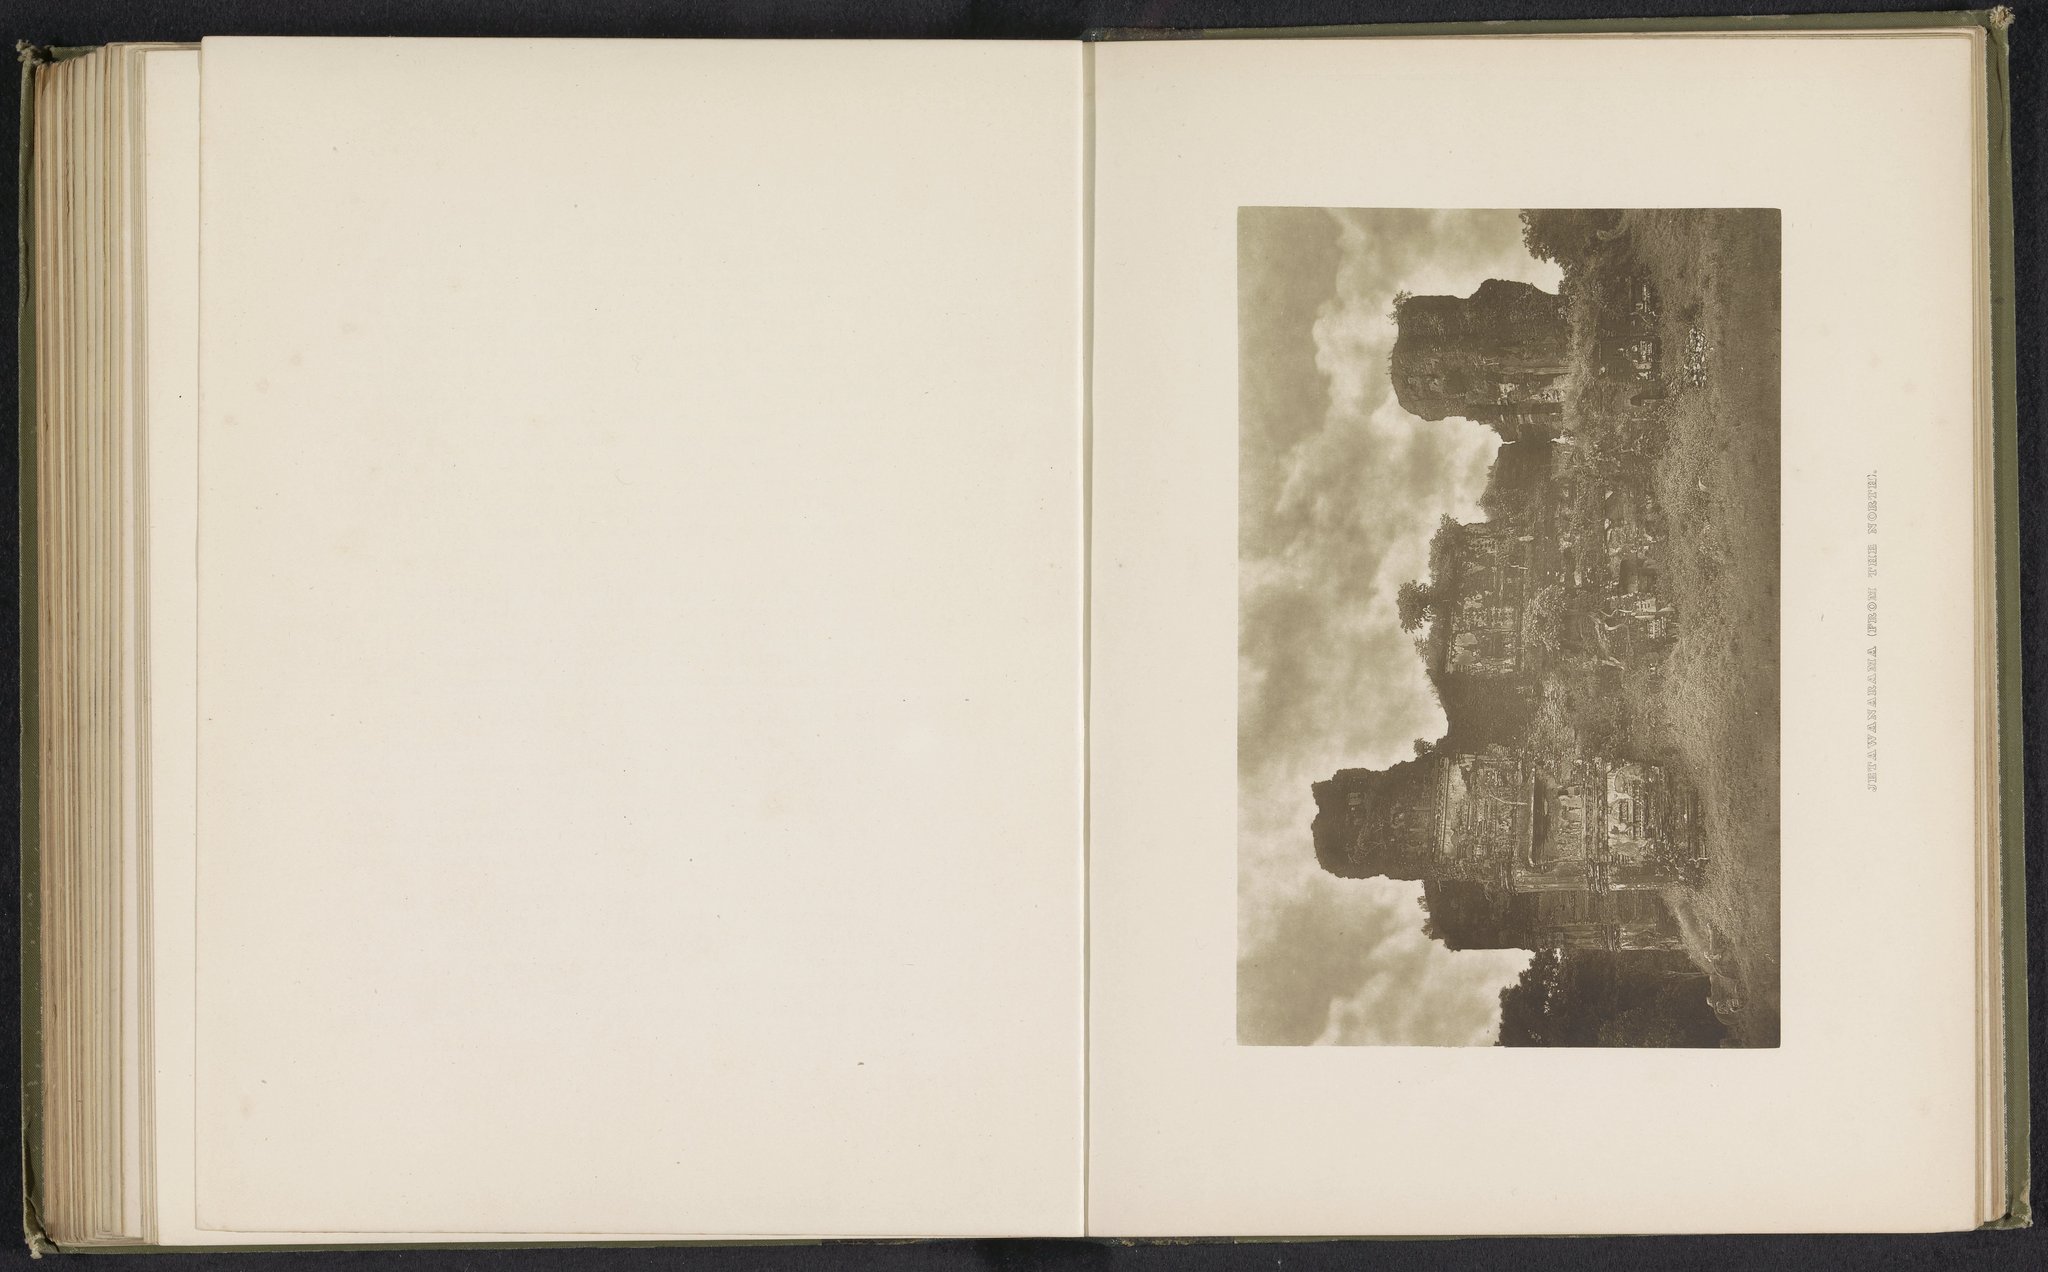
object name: photomechanical print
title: Ruins of the Lankatilaka Vihara at Polonnaruwa, Sri Lanka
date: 1896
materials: paper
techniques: woodburygravure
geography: polonnaruwa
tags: temple, shrine ~ hinduism, buddhism, jainism, ruin of a building ~ architecture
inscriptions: title: ‘JETAWANARAMA (FROM THE NORTH).’